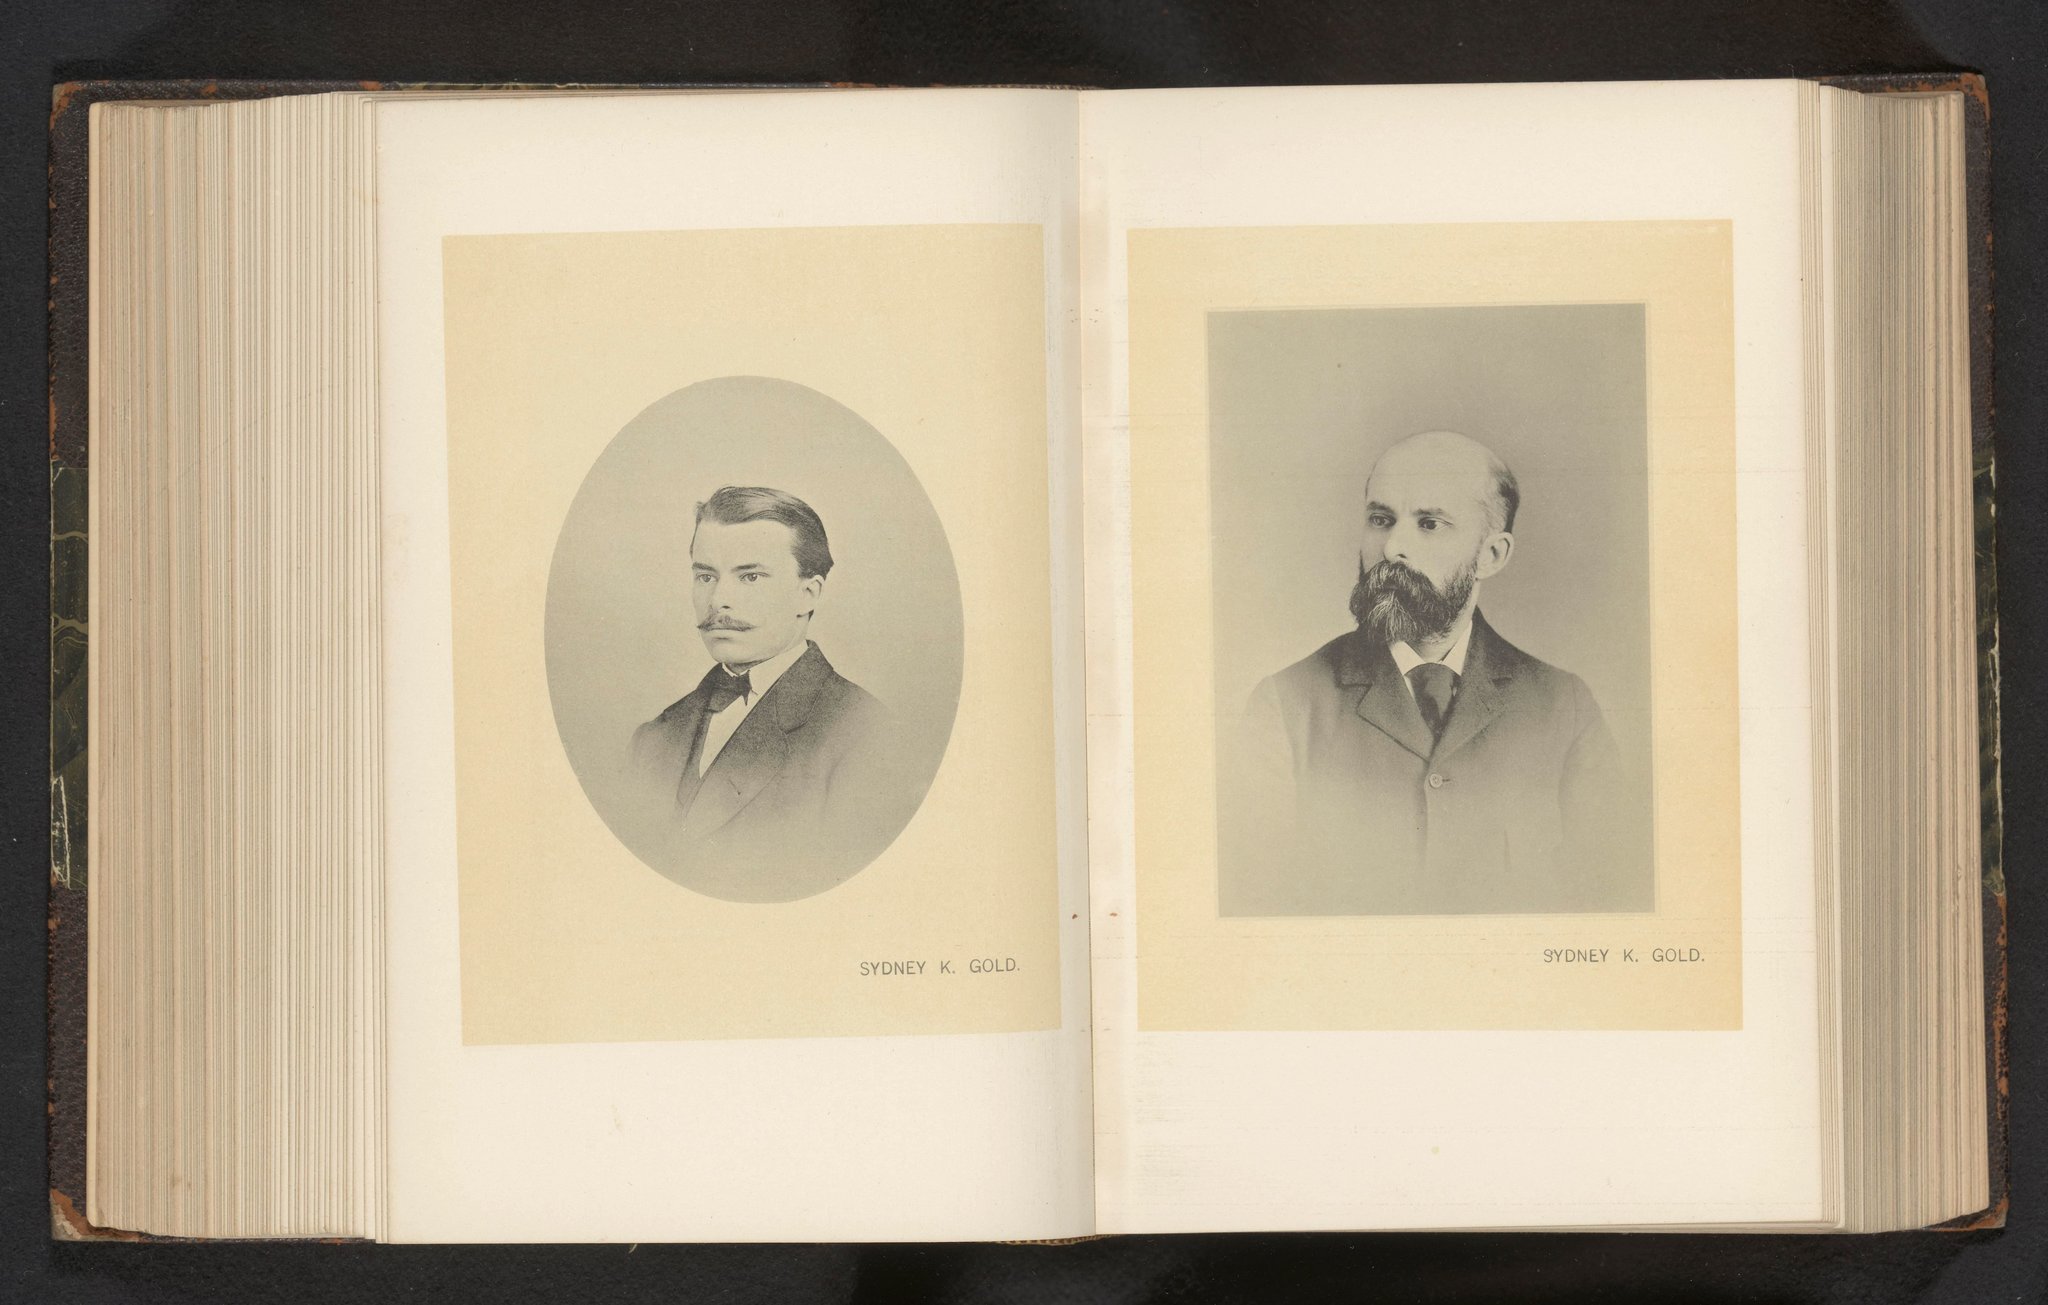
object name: page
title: Sydney K. Gold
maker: Anonymous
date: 1869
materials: paper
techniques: photoaquatint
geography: boston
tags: adult man